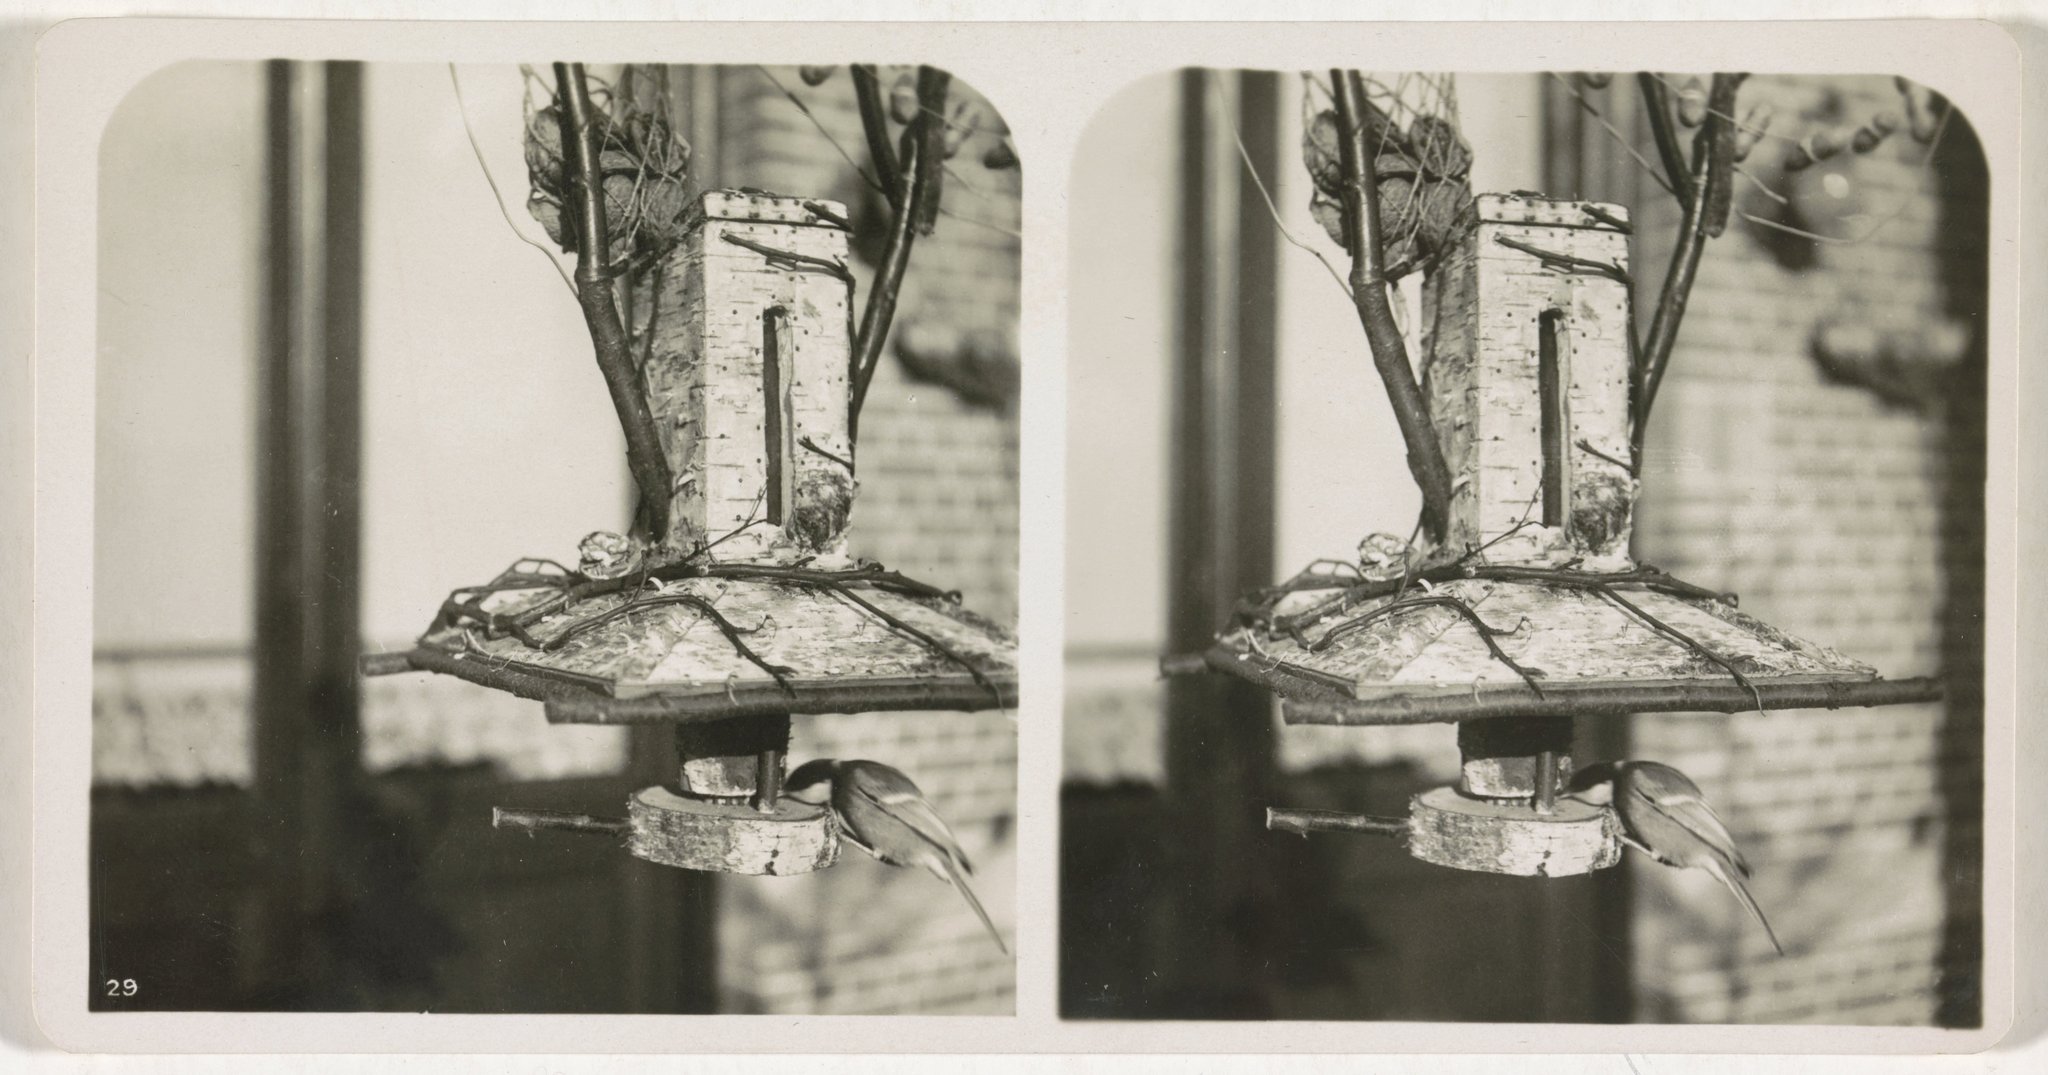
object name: stereograph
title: Koolmees onderaan voederhuisje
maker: adolphe burdet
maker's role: fotograaf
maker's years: 1860-1940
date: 1870-1940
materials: photographic support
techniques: gelatin silver print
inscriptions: label: ‘29 / Parus major L. / Mésange charbonnière / Koolmees...’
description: Linksonder op de foto links staat het nummer 29. Uit serie van 25 stereofoto's.